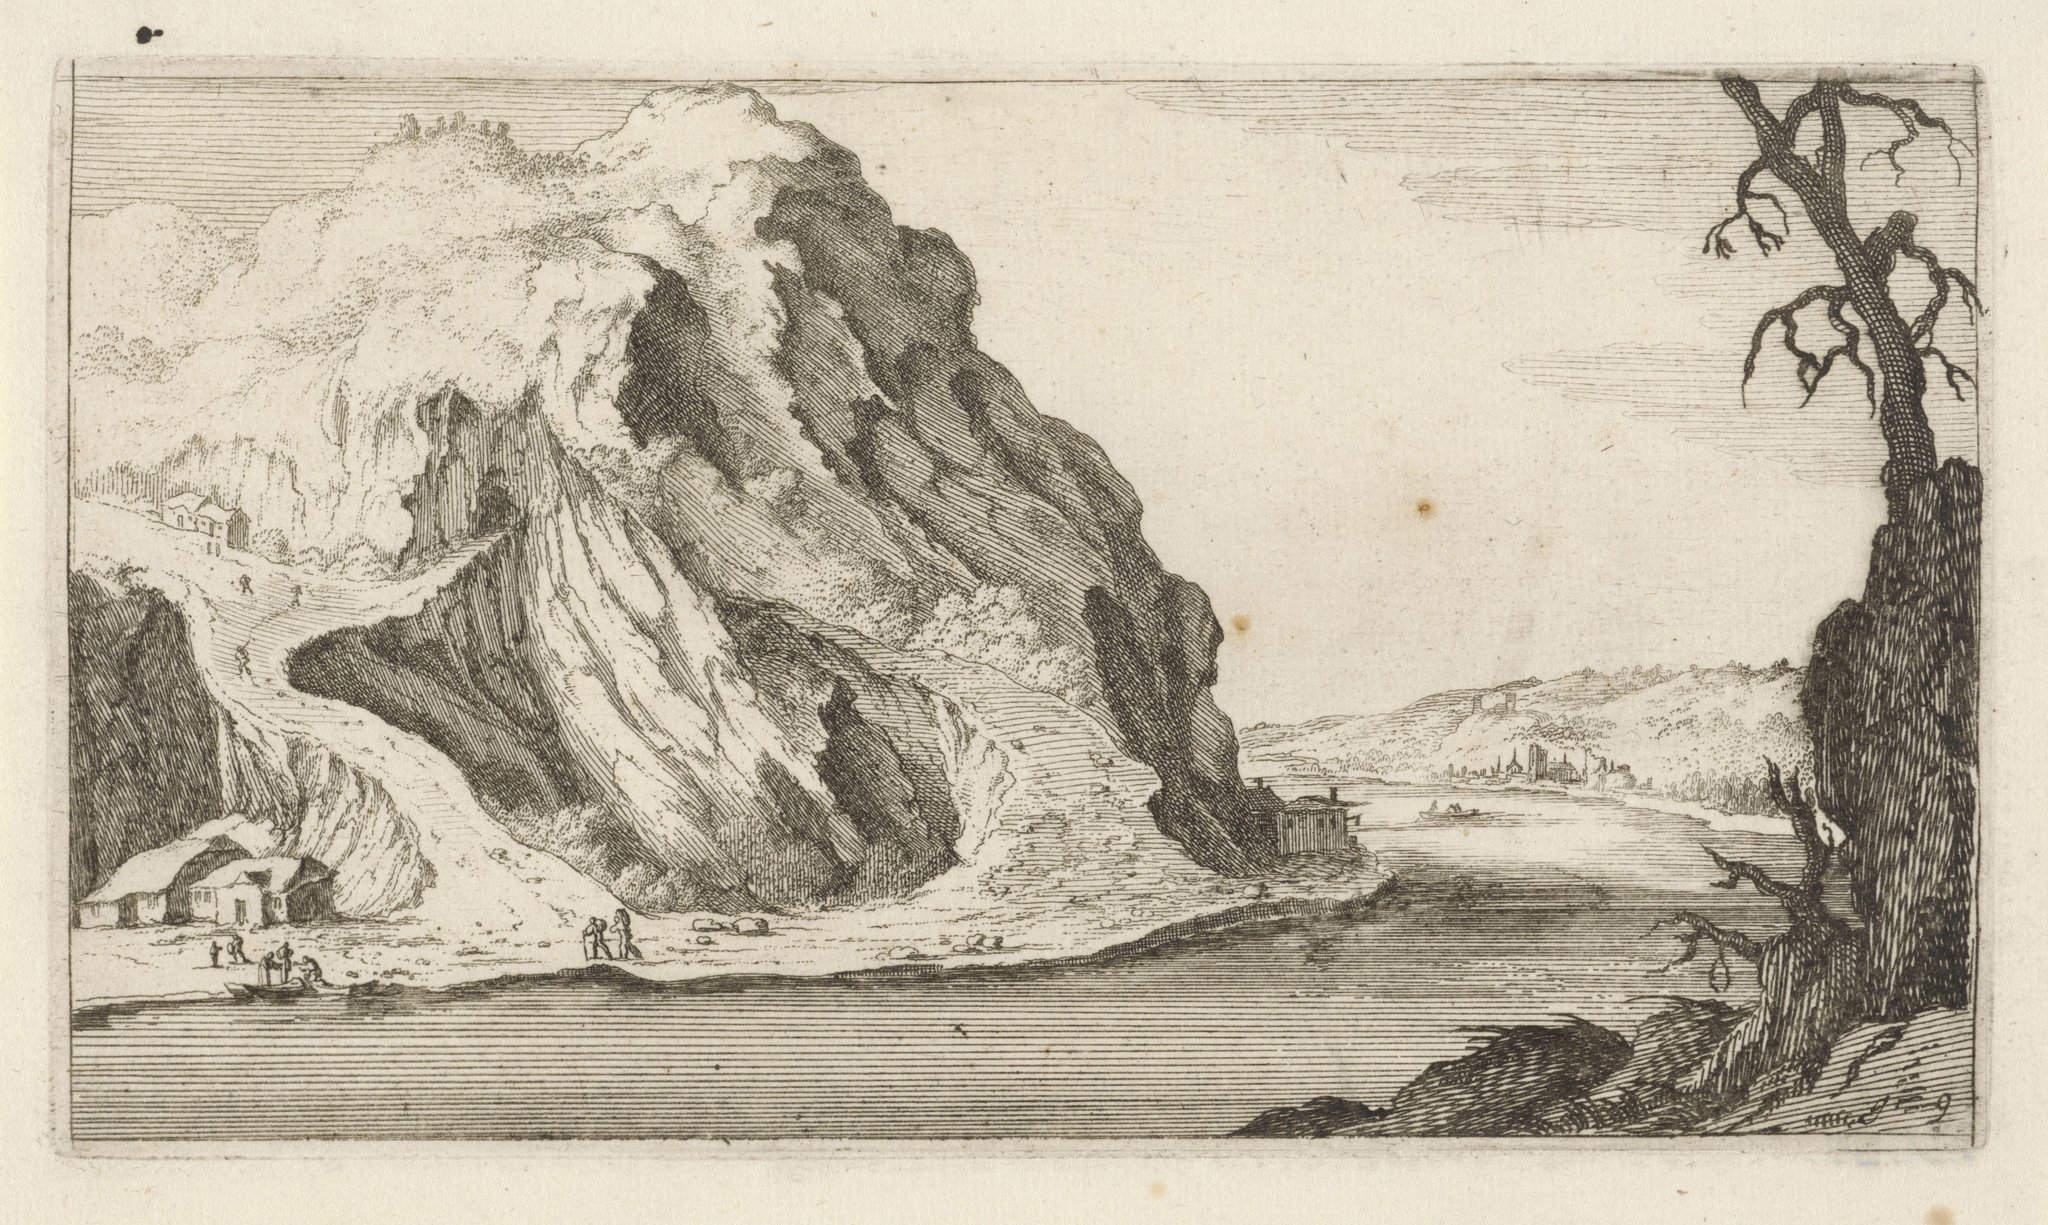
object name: print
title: Rivier in de bergen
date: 1640-1706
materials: paper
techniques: etching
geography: amsterdam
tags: river, mountains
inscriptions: collector's mark: Lugt 2165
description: Gezicht op een landschap met een berg waar een brede rivier langs stroomt. Aan de waterkant verschillende figuren. De prent maakt deel uit van een serie van twaalf landschappen.